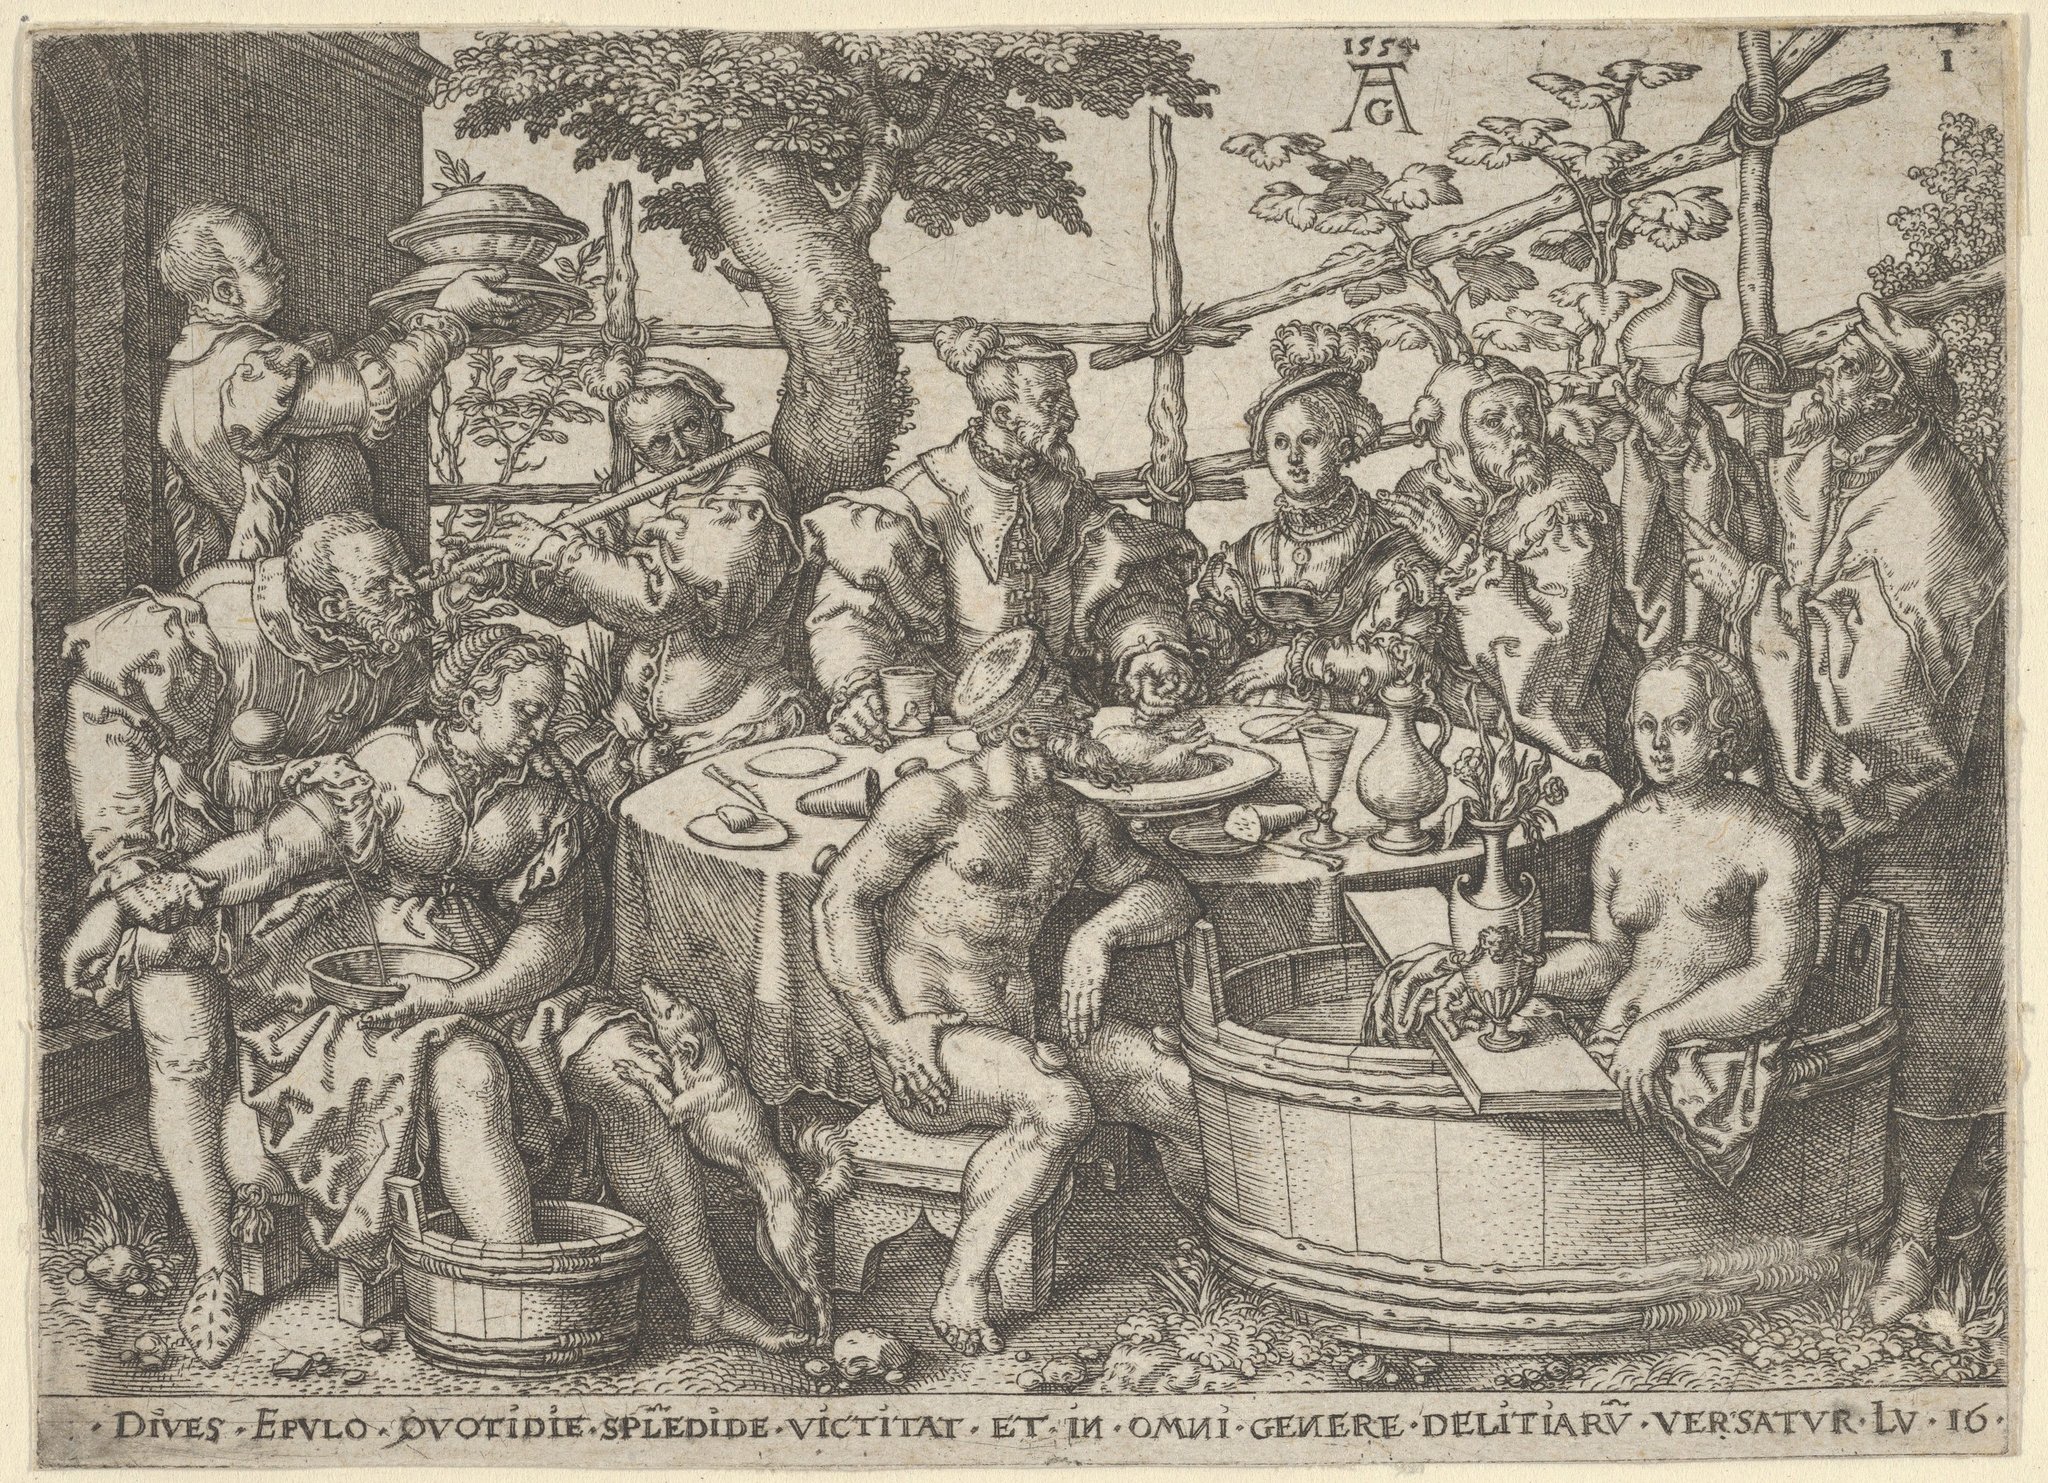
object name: print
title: The Rich Man at His Table, from "The Parable of the Rich Man and Lazarus"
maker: heinrich aldegrever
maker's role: artist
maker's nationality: german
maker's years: 1502-1561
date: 1554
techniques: engraving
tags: men,male nudes,women,dogs,drinking,tables